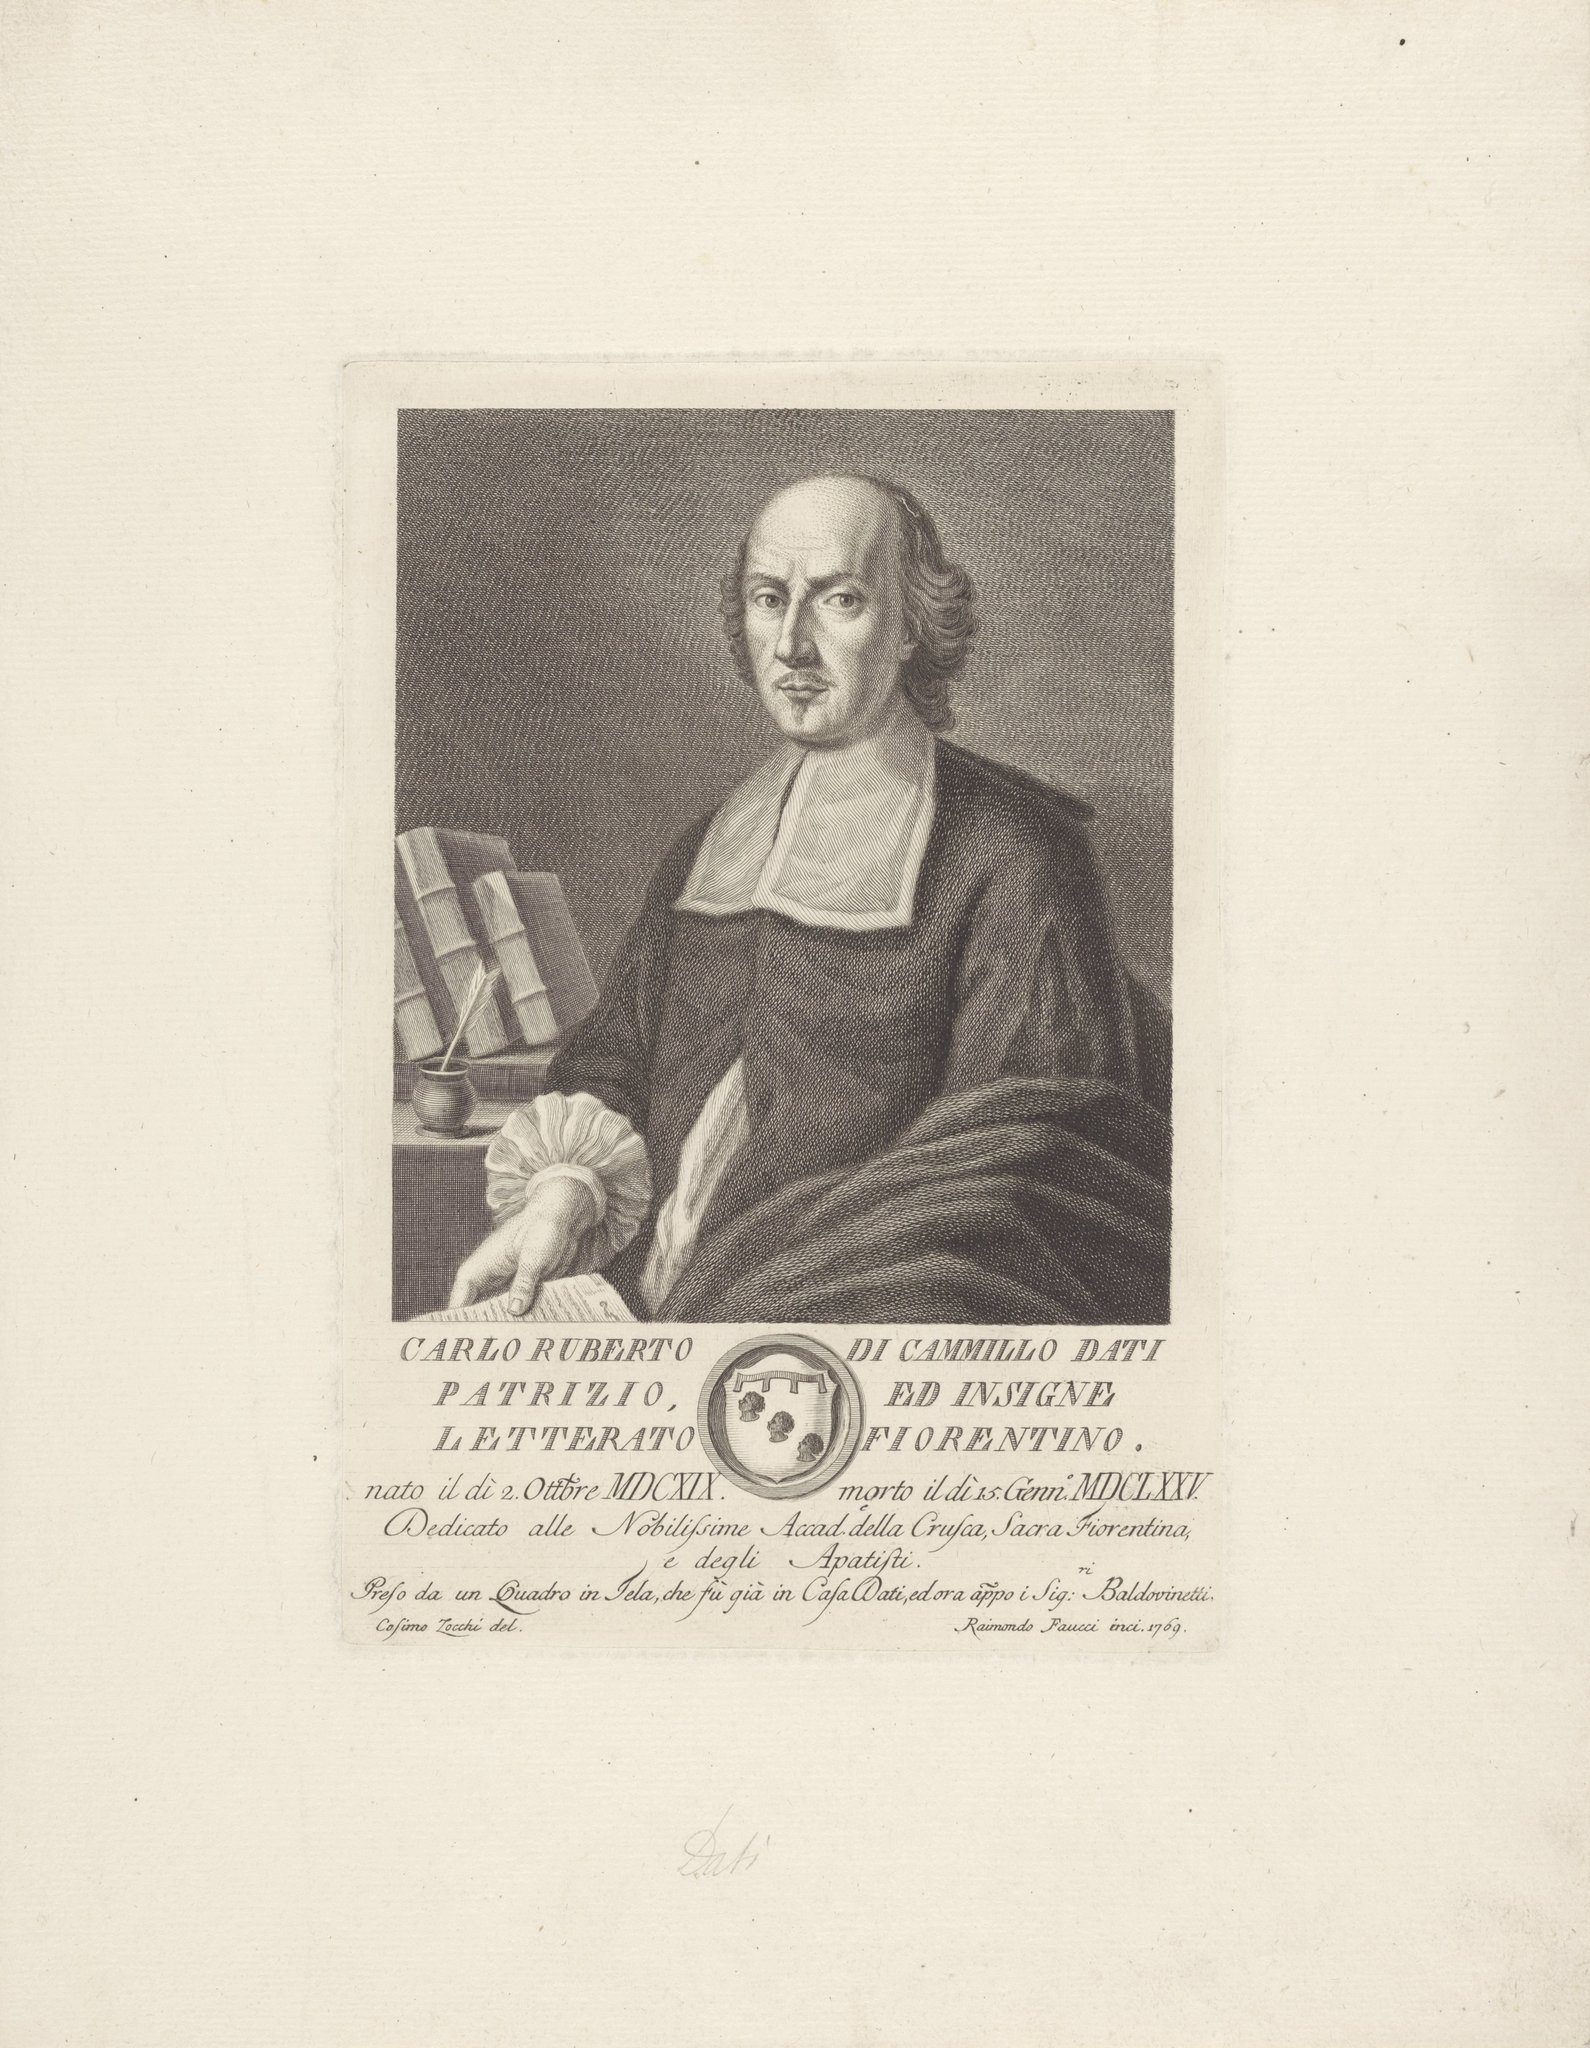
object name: print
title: Portretten van beroemde Italianen met wapenschild in ondermarge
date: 1769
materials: paper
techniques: engraving, etching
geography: italy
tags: historical persons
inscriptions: collector's mark: Lugt 2228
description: Deze prent maakt deel uit van een reeks portretprenten van onbekende omvang. De prenten zijn gemaakt door meedere prentmakers, onder wie Francesco Allegrini en Carlo en Raimondo Faucci.